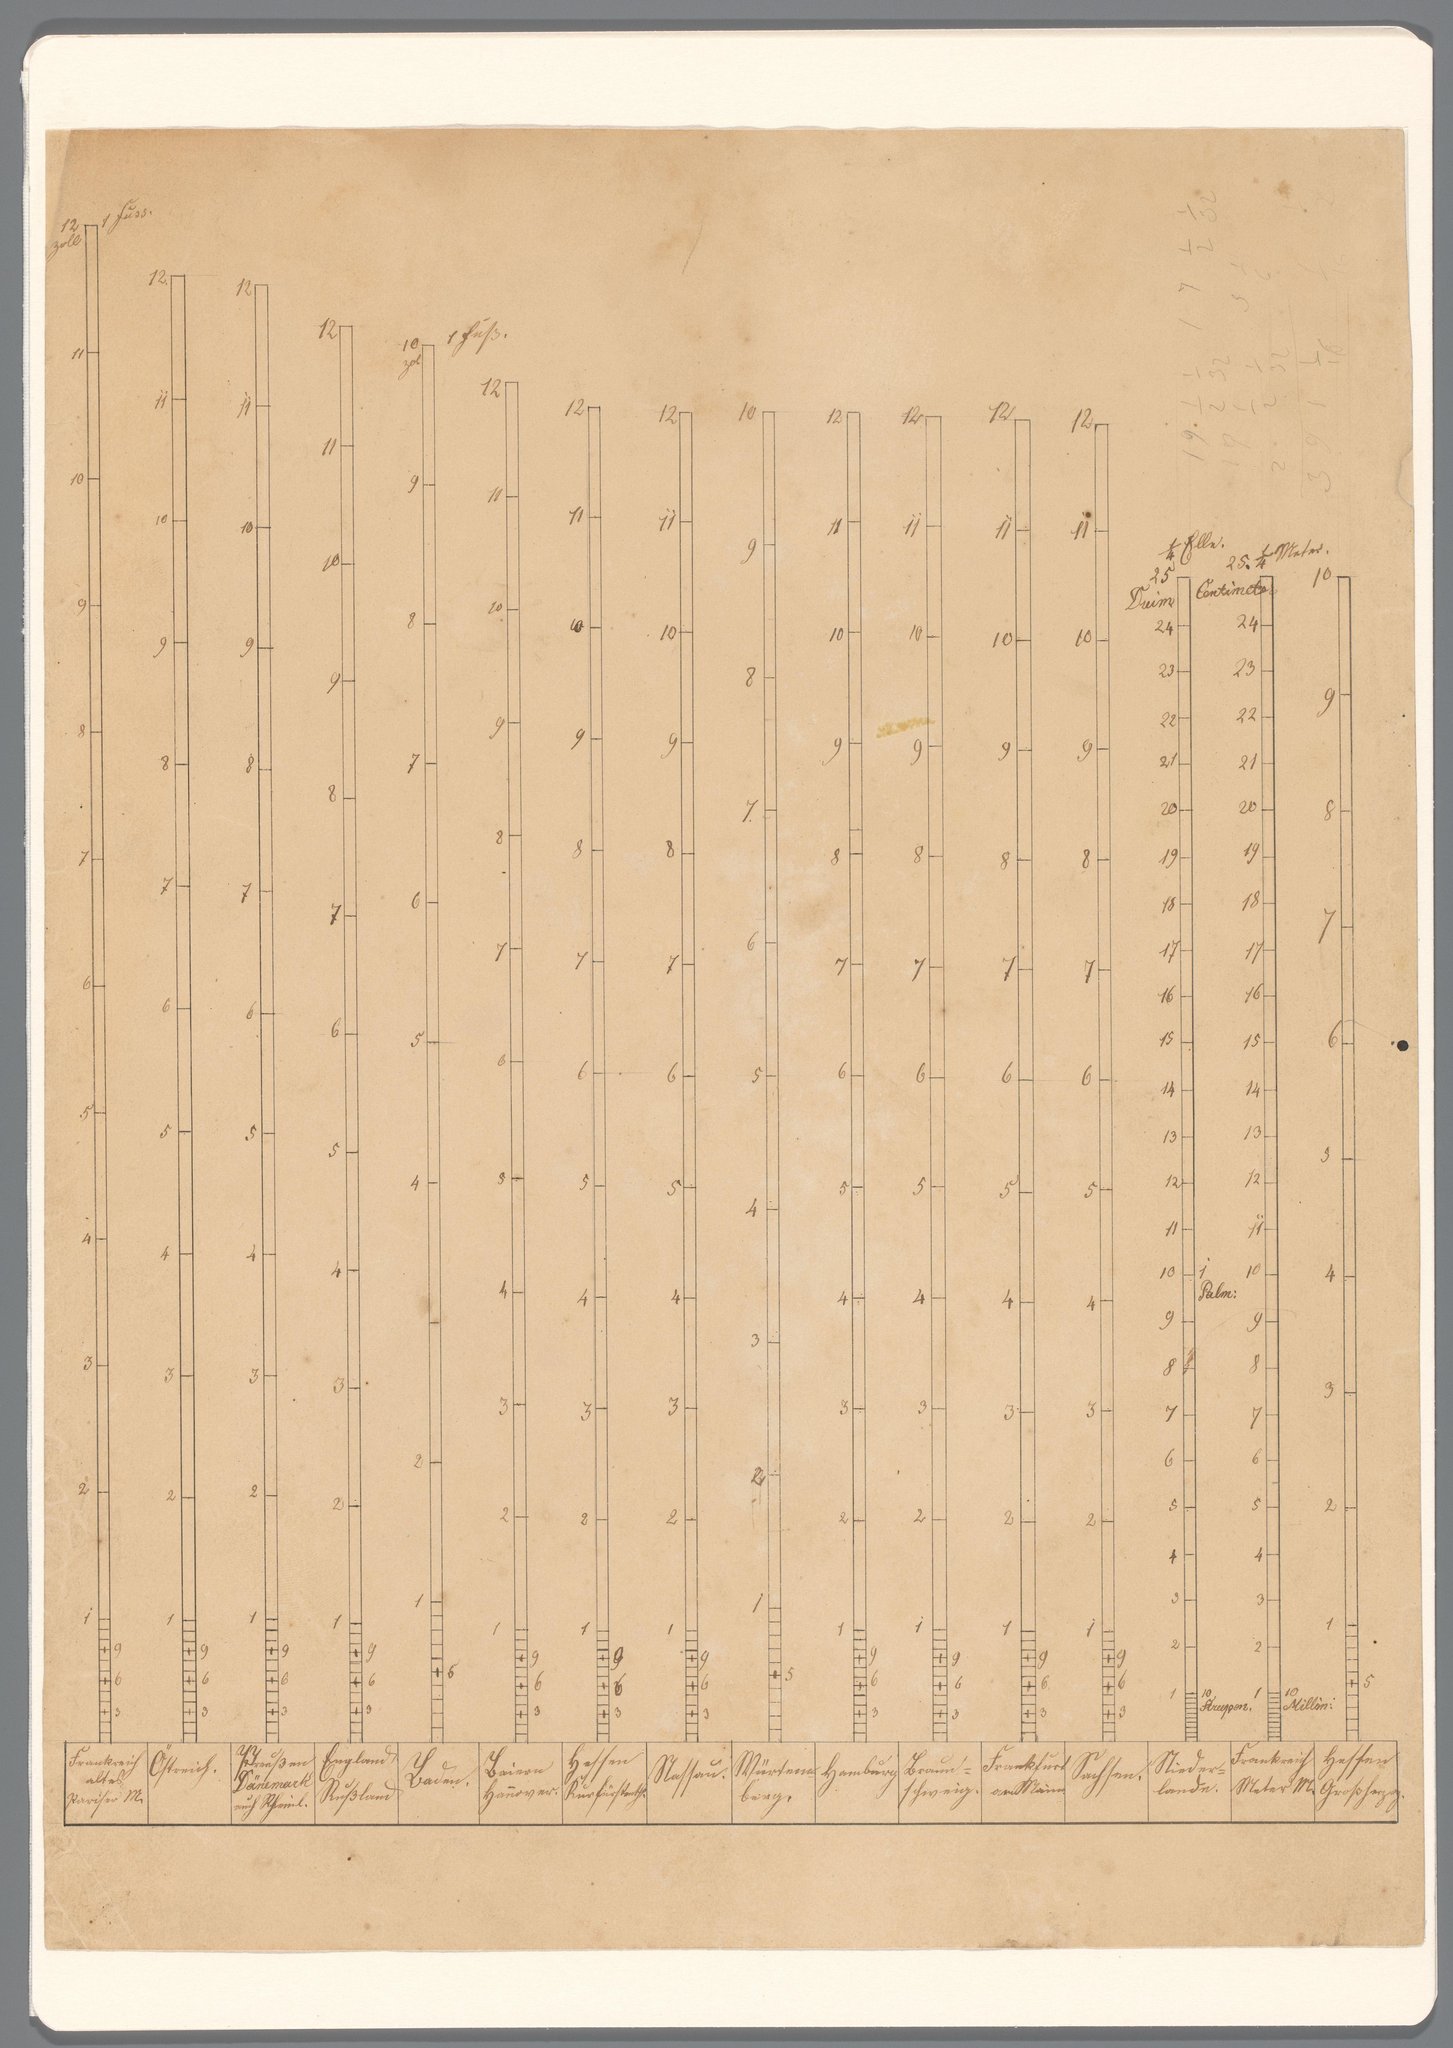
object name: drawing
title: Tabel van 16 verschillende voetmaten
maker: b. winghofer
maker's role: draughtsman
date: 1852-1855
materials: ink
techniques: drawing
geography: mainz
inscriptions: inscription: ‘berekeningen in grafiet’